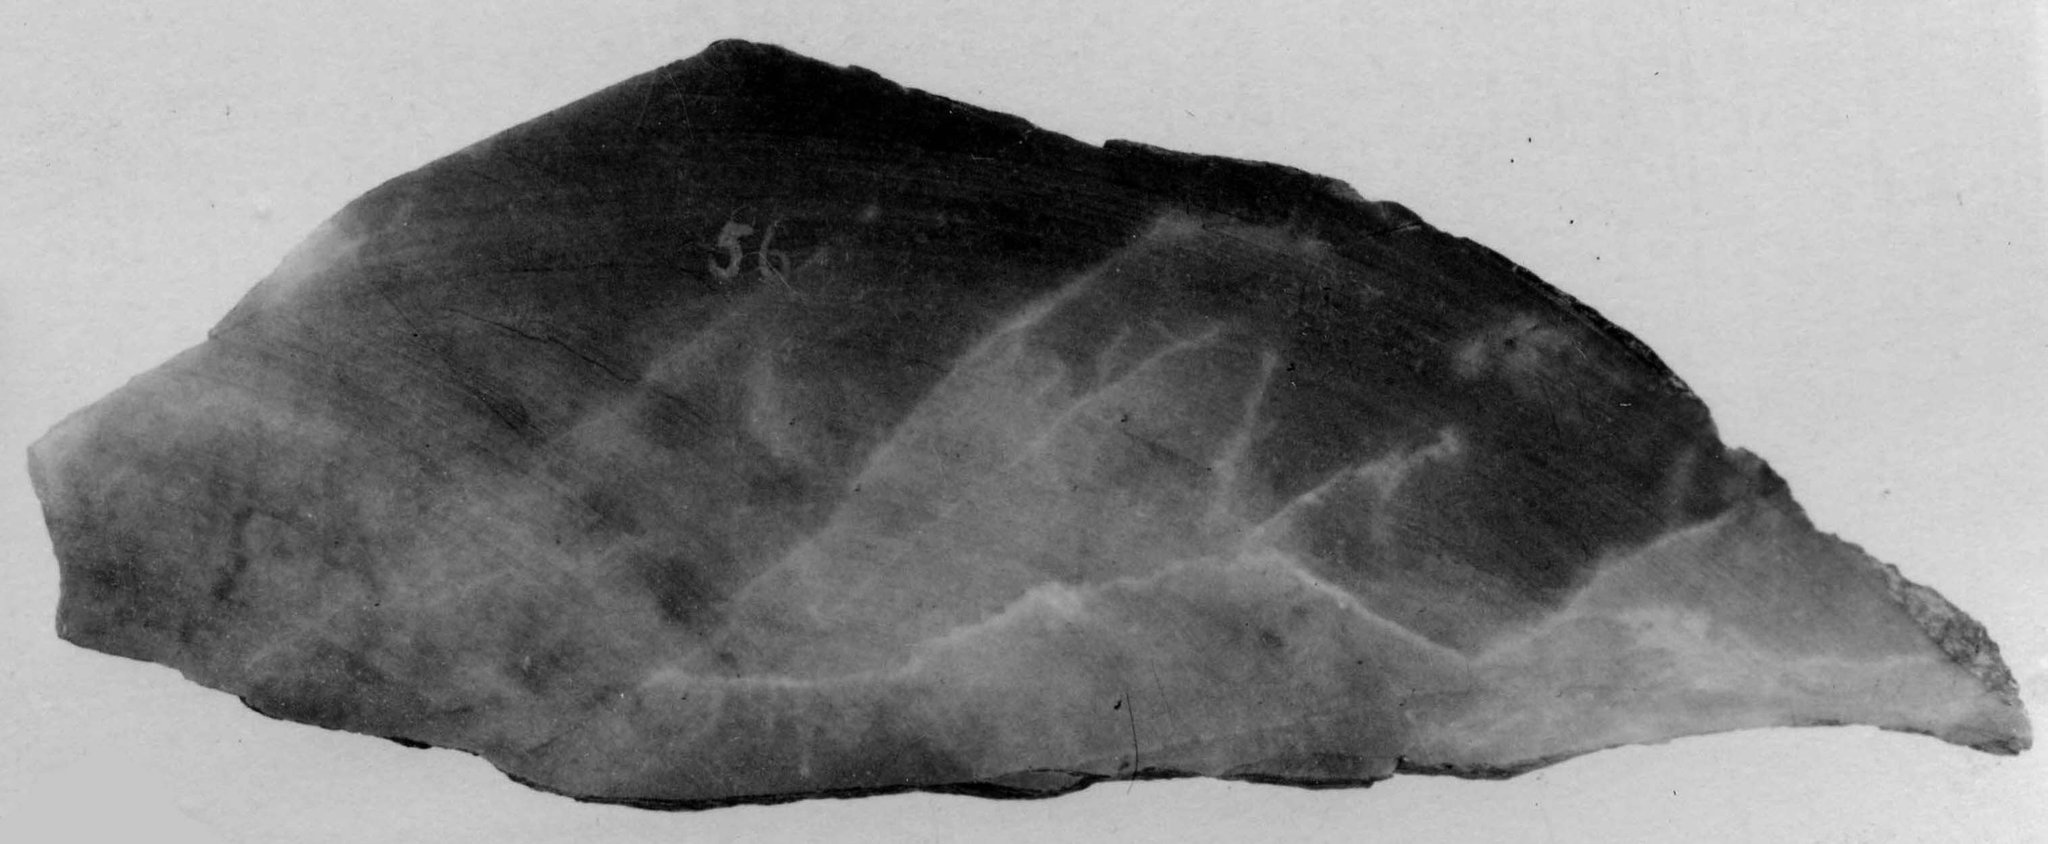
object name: fragment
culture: tibetan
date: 1902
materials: jade